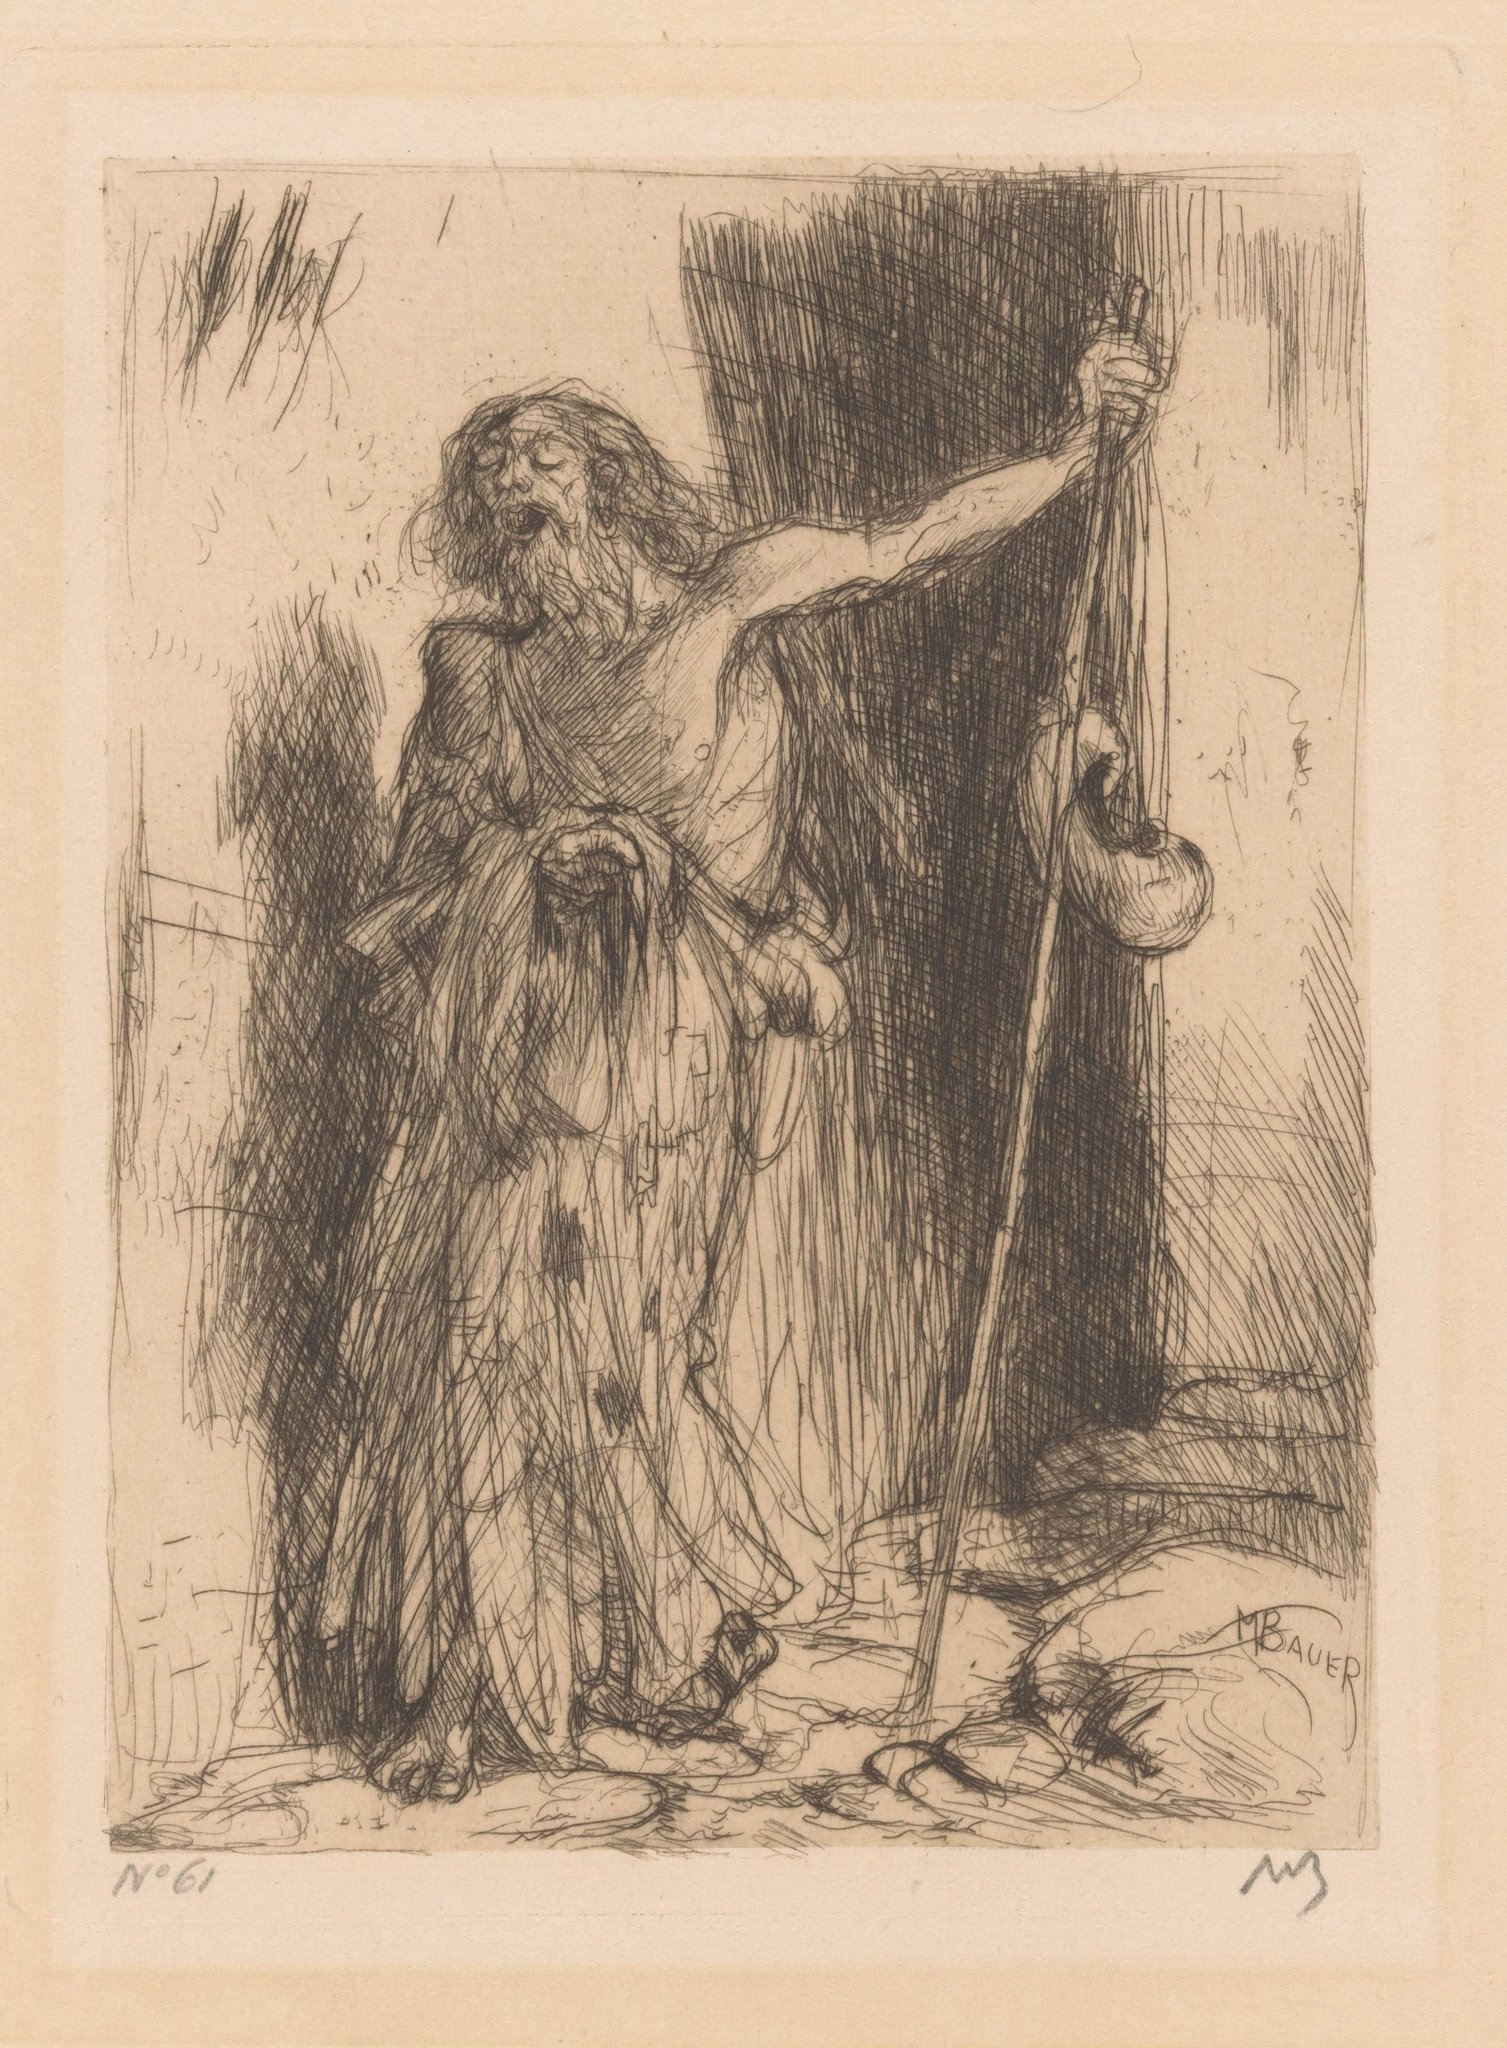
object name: print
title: Blinde bedelaar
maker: marius bauer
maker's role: draughtsman, print maker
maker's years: 1867-1932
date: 1900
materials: paper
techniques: etching, intaglio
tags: blind, blindness, beggar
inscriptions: collector's mark: Lugt 2760, collector's mark: Lugt 2228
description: Een staande man die gekleed is in lompen en leunt op een stok.